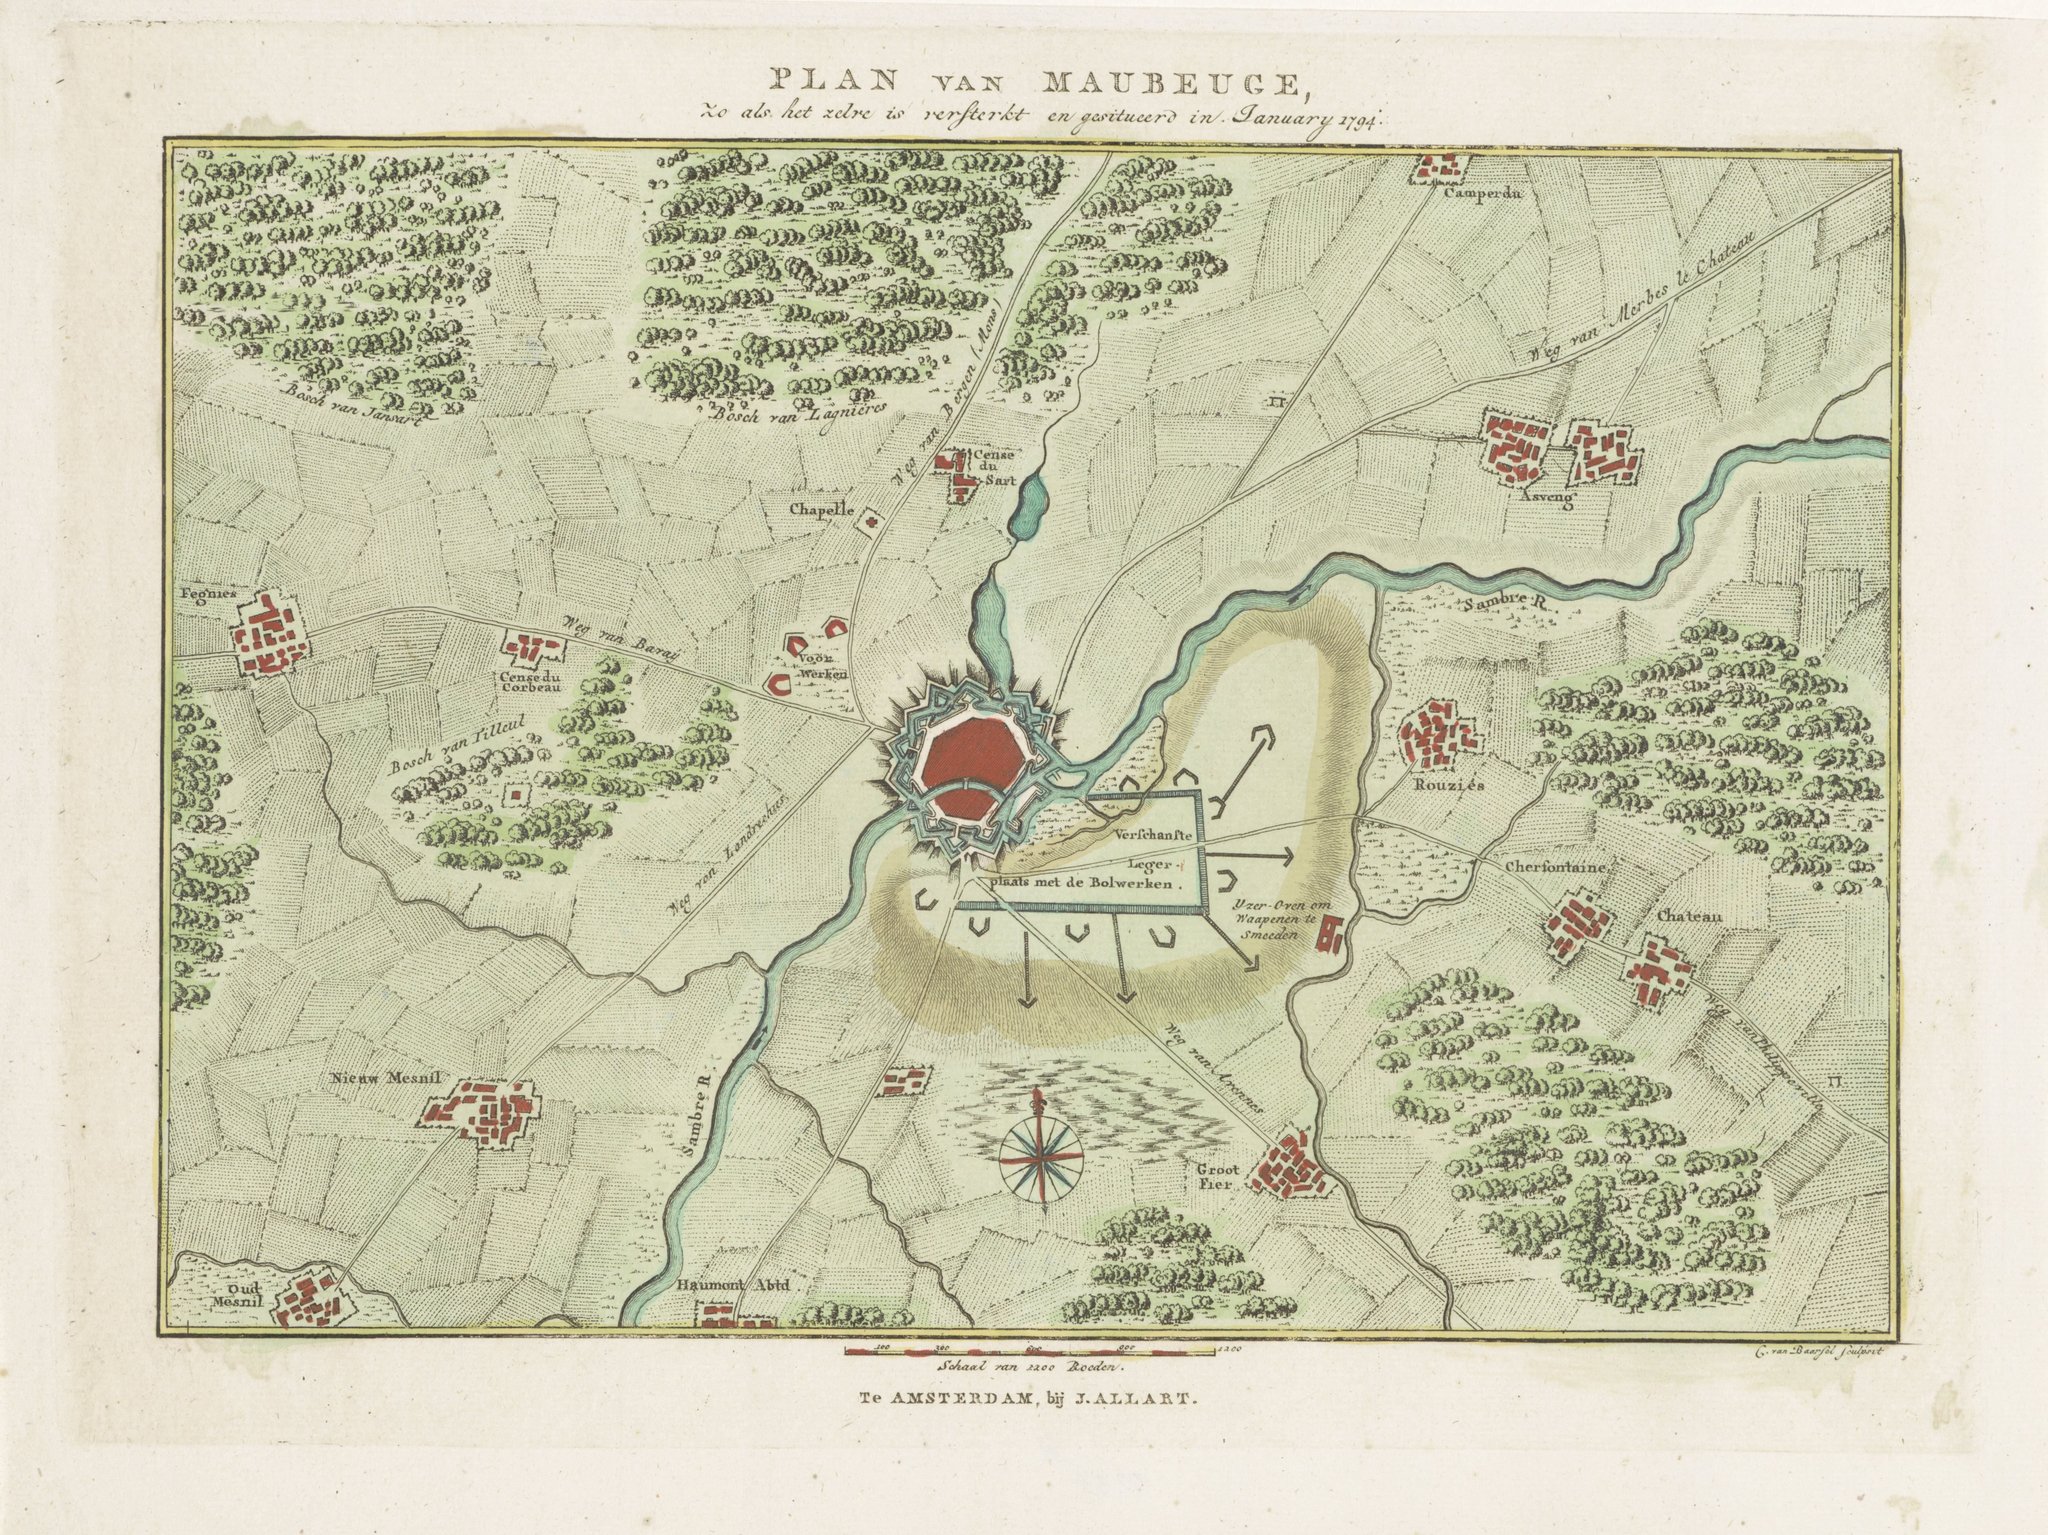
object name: map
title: Plan van de versterkingen van Maubeuge, 1794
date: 1794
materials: paper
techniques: engraving, etching, hand coloring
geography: northern netherlands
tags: fortified city, maps of cities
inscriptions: collector's mark: Lugt 2228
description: Plattegrond van de versterkingen om de stad Maubeuge, in januari 1794. Onderdeel van een serie van zeven bladen met plattegronden van versterkte steden in de Oostenrijkse Nederlanden ten tijde van de tweede Franse inval onder generaal Pichu in 1794.